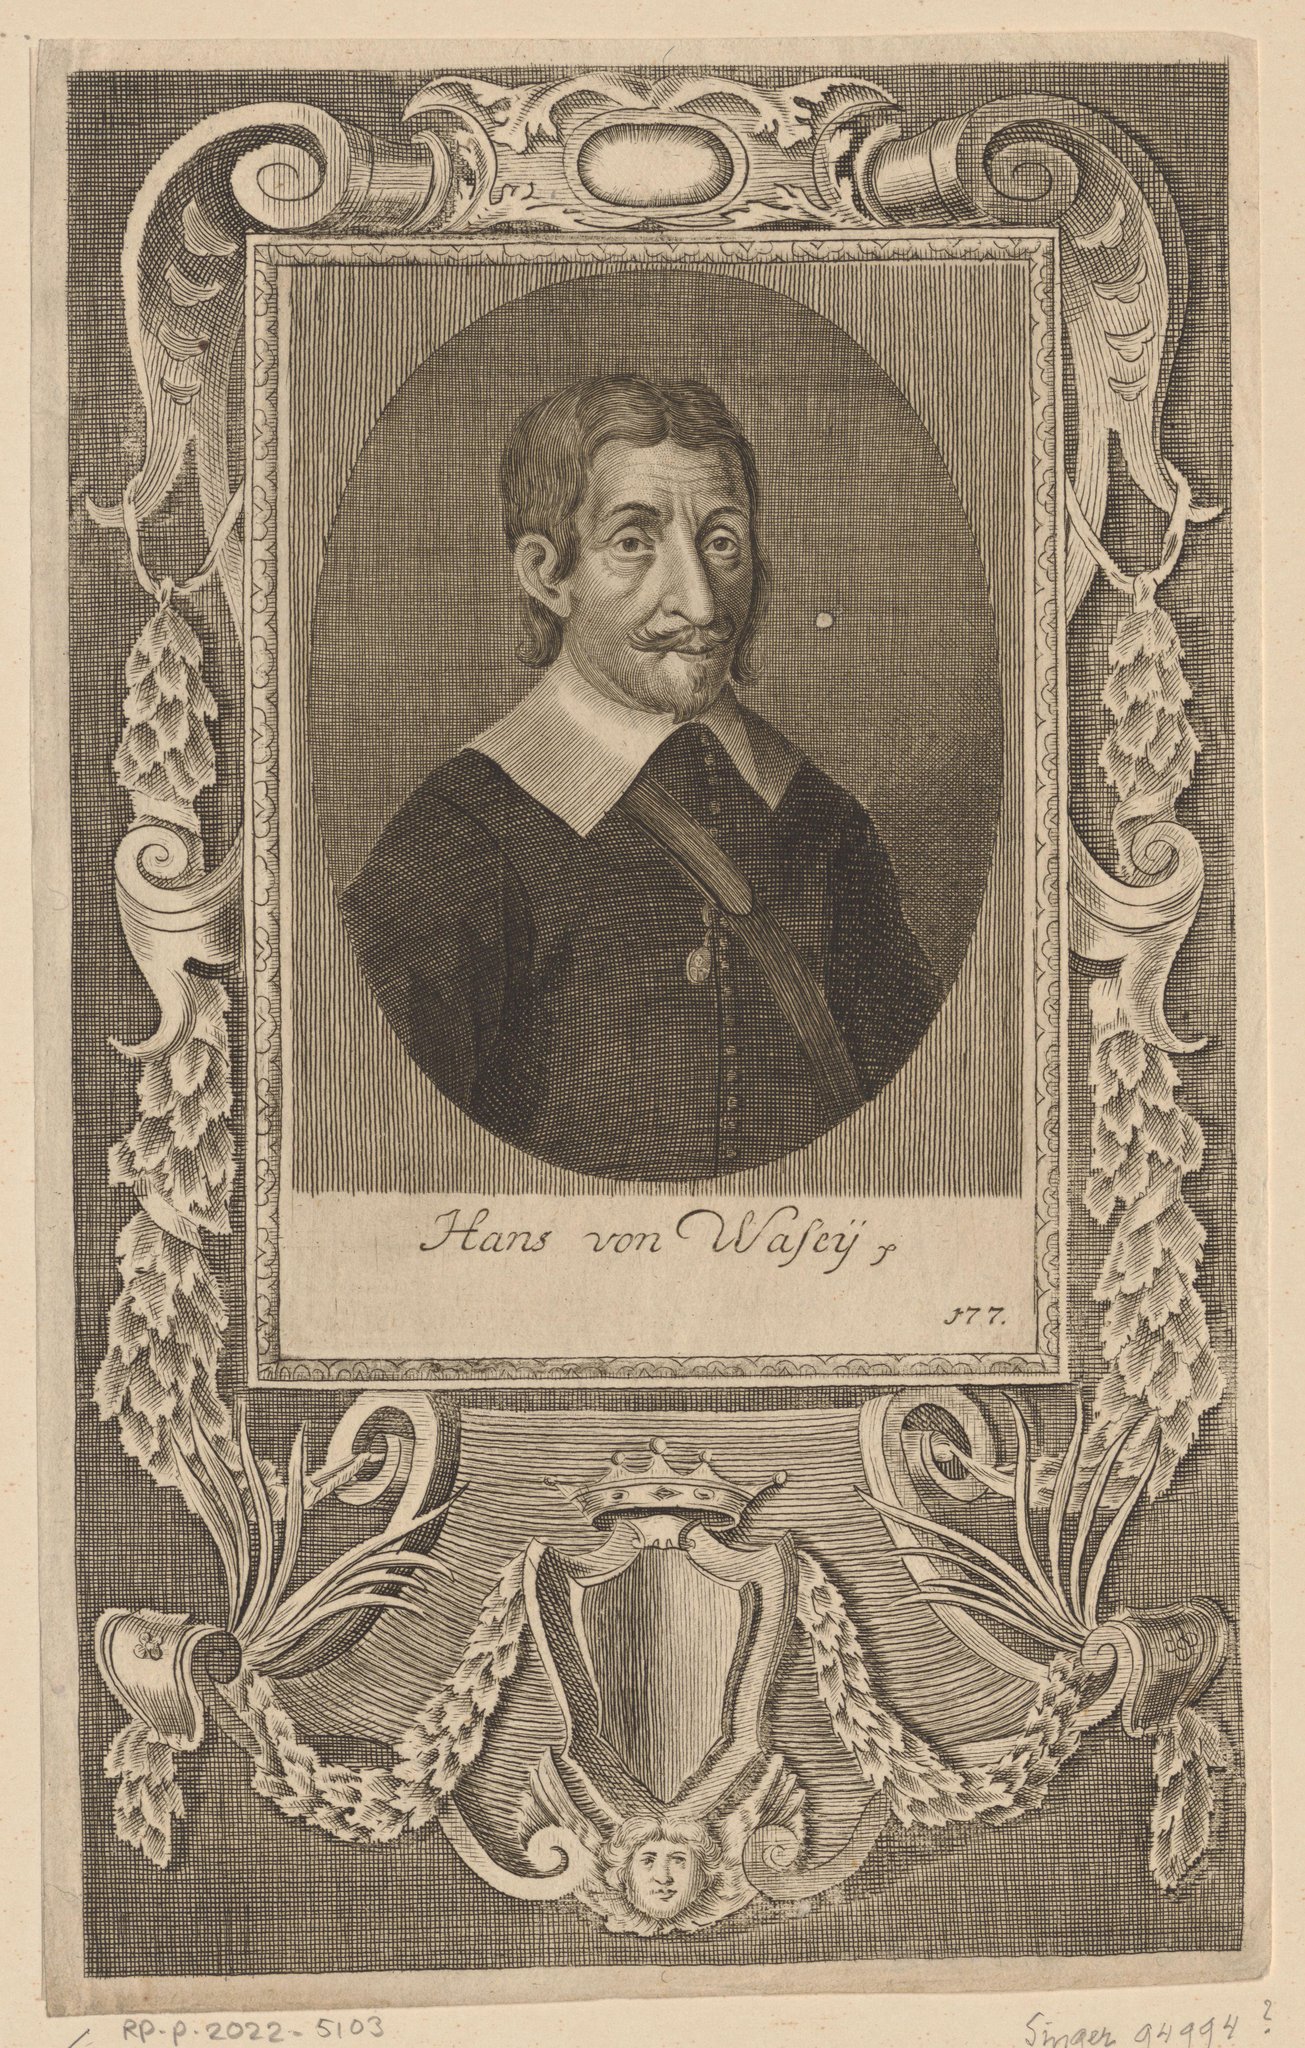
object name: print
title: Portret van Hans von Wasey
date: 1722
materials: paper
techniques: engraving, etching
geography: germany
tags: historical persons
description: Omlijsting van de prent ook gebruikt in: Khevenhüller, Franz Christoph. Conterfet Kupfferstich (...). Leipzig: Moritz Georg Weidmann, 1721-22. Prent vertoont overeenkomsten met de portretten in dit werk, maar komt hier niet in voor.